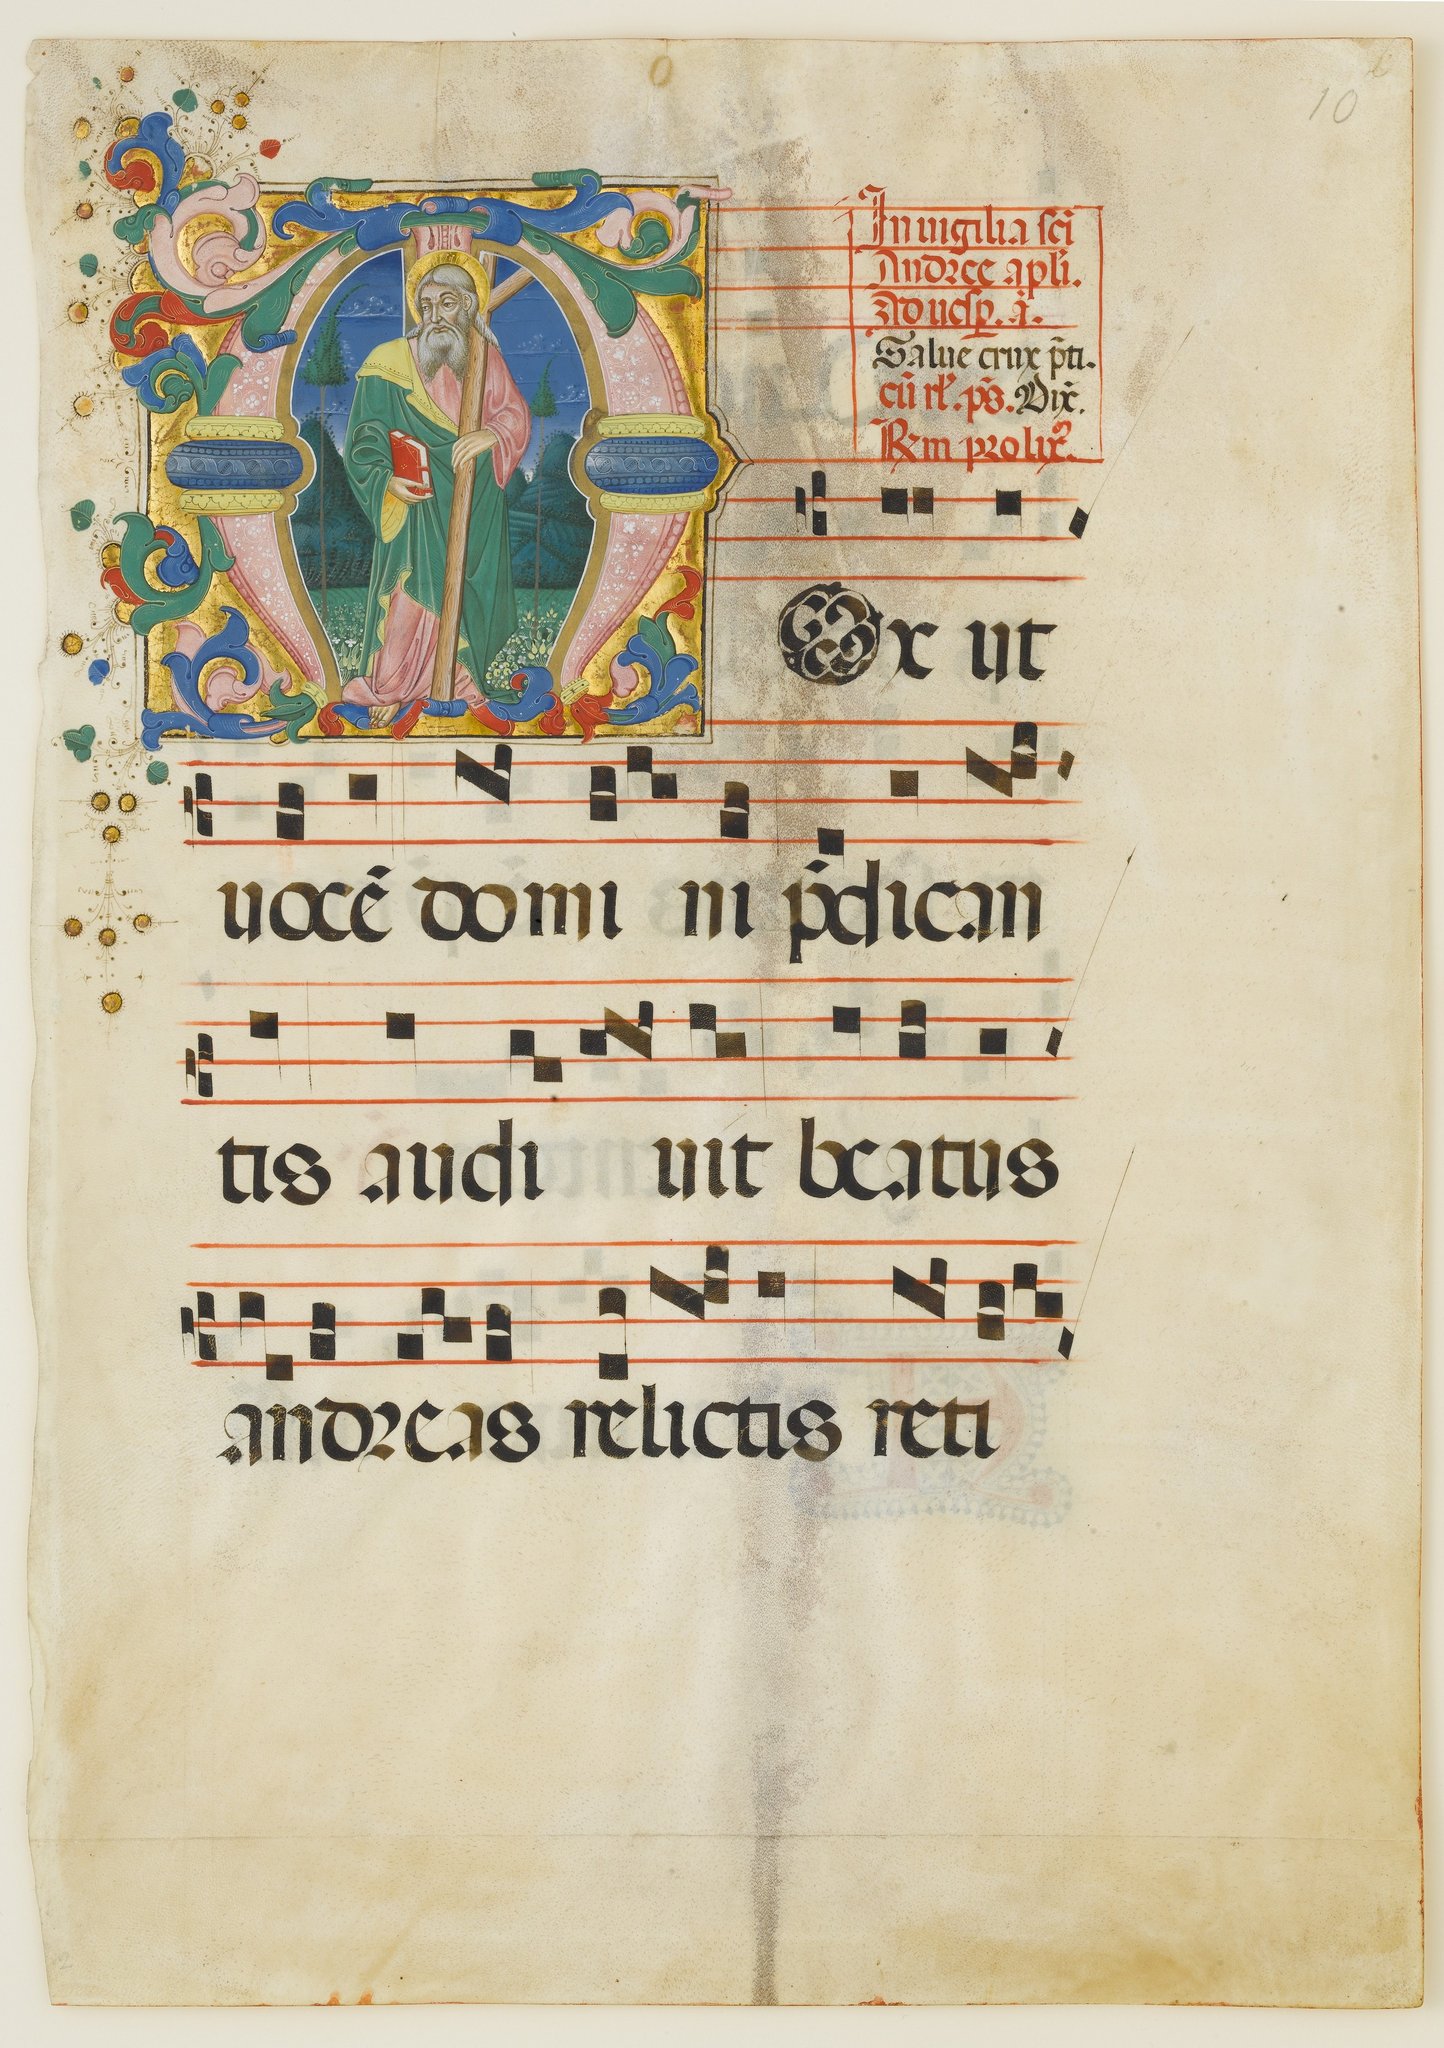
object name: antiphonary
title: Manuscript Leaf with the Feast of Saint Andrew in an Initial M, from an Antiphonary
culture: italian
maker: master of the riccardiana lactantius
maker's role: artist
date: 1451-1500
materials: gold, ink, parchment, paint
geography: italy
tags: music